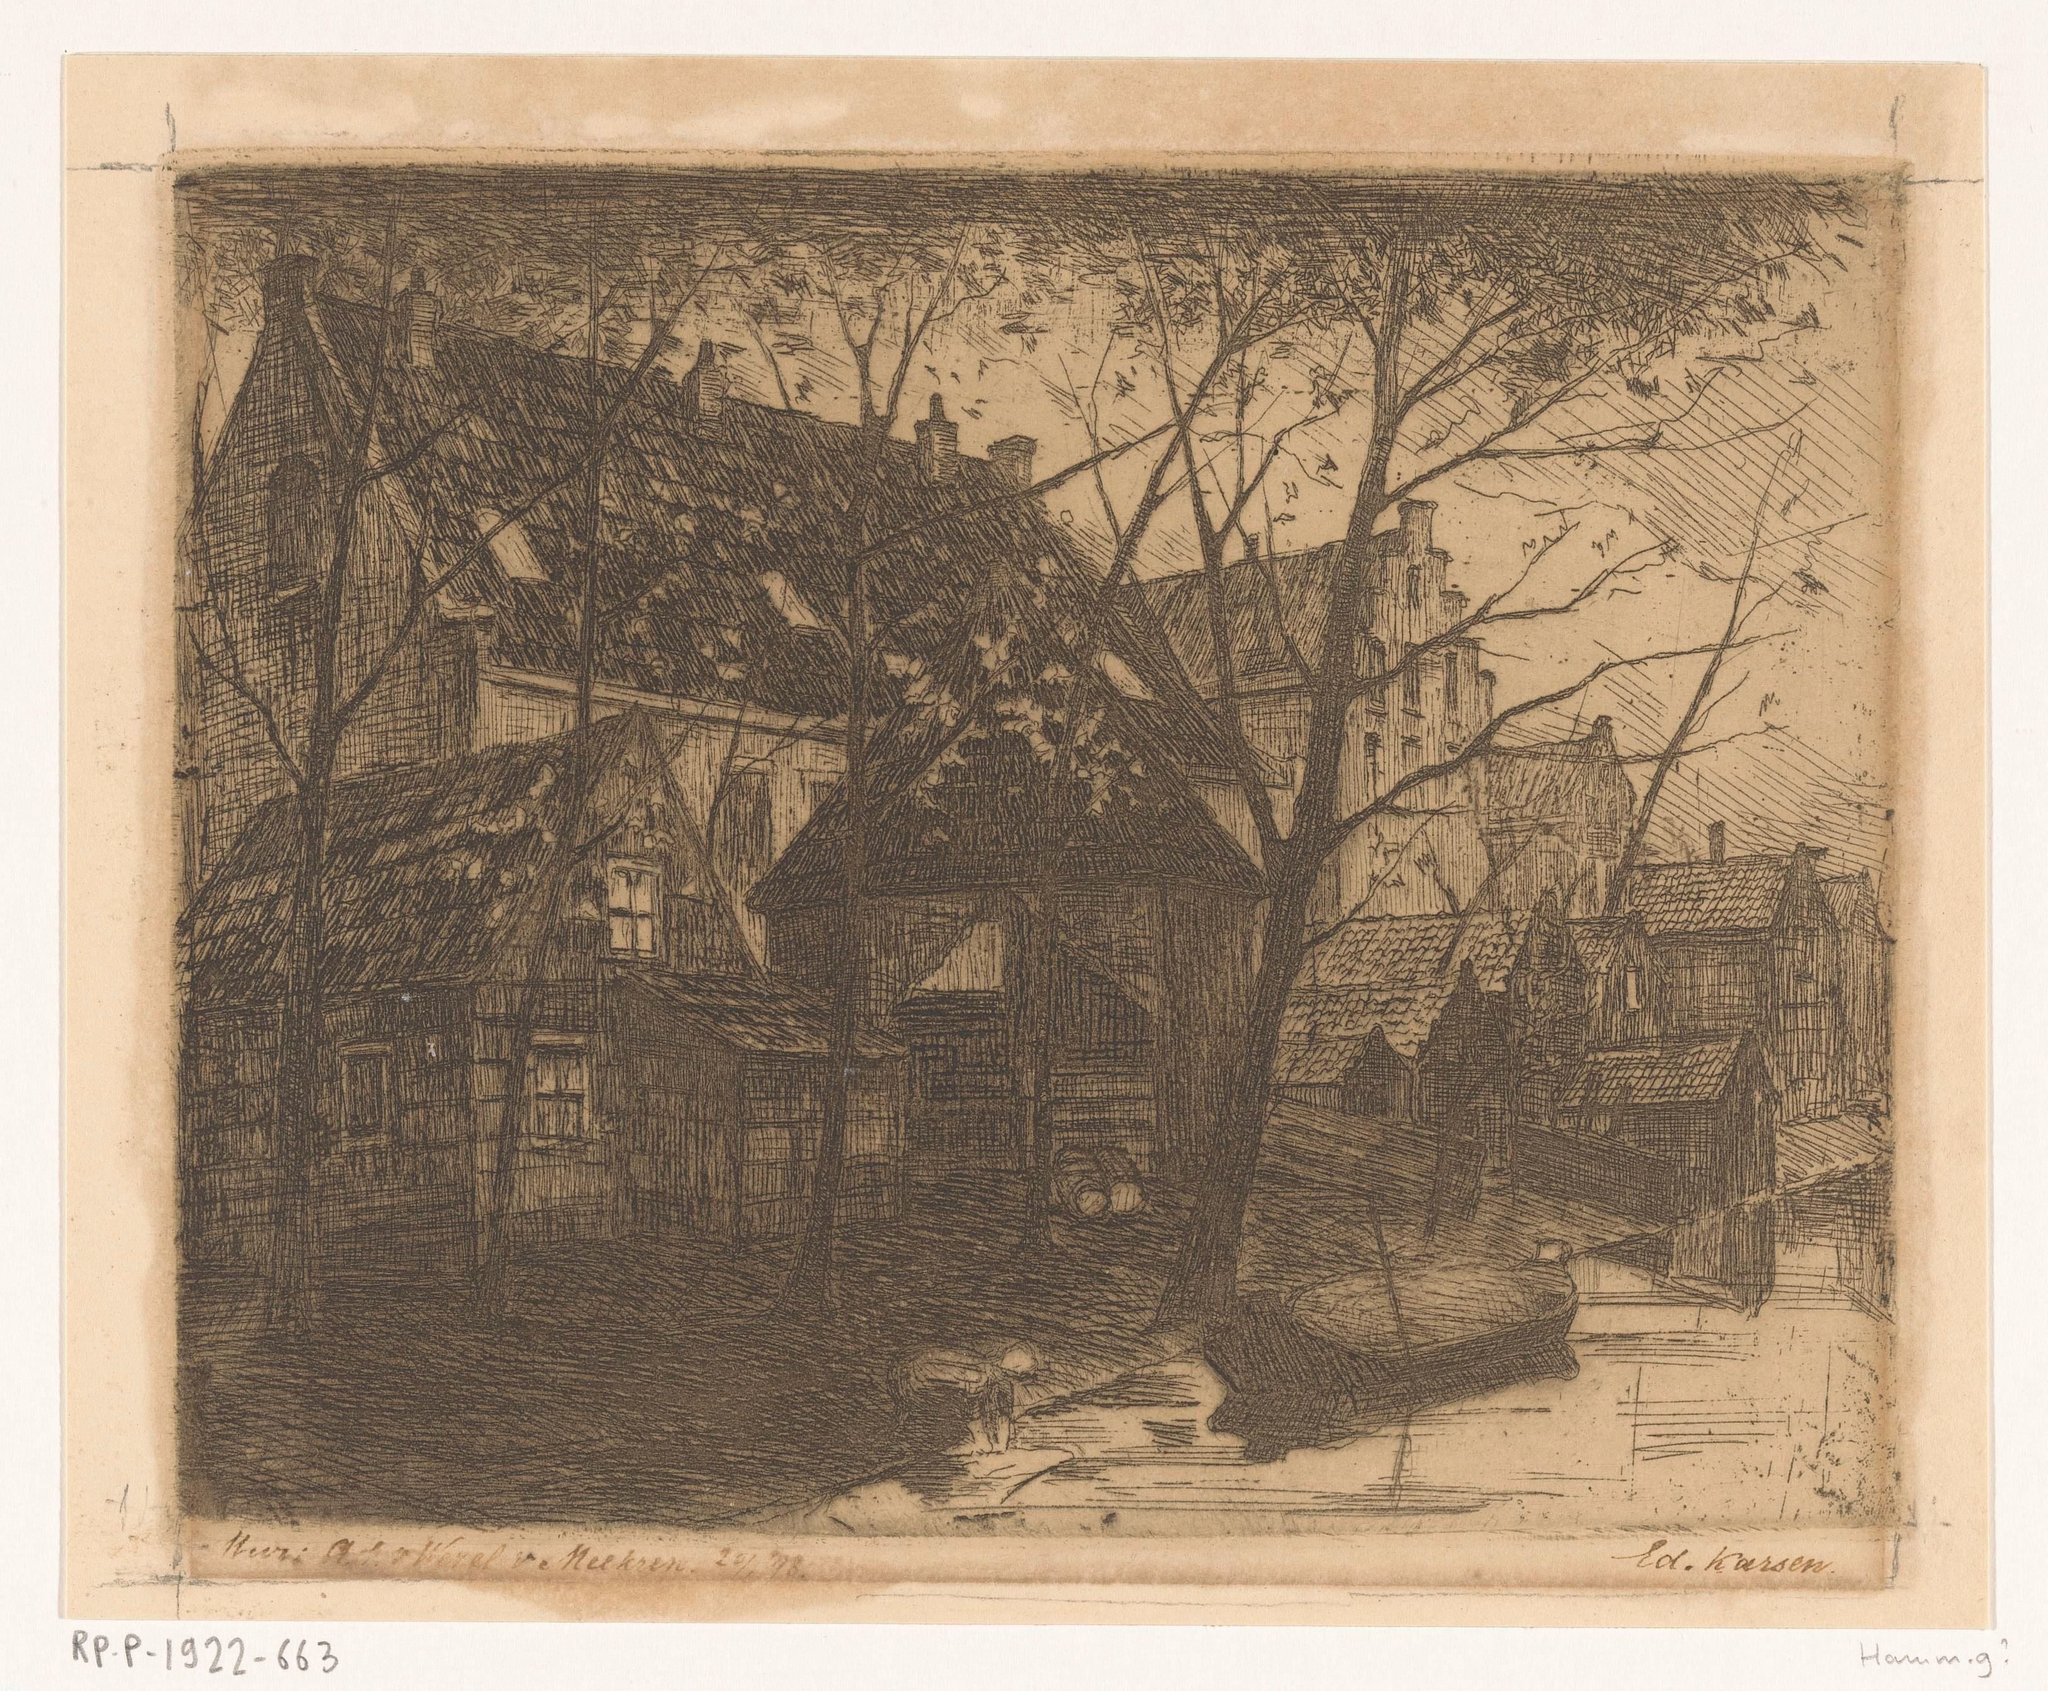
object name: print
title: Achterkanten van huizen langs het water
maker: eduard karsen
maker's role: draughtsman, painter, print maker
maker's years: 1860-1941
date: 1870-1922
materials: paper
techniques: etching, intaglio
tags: garden, small canal, ditch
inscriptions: collector's mark: Lugt 2228, inscription: ‘Heer A. van Wezel [...]’